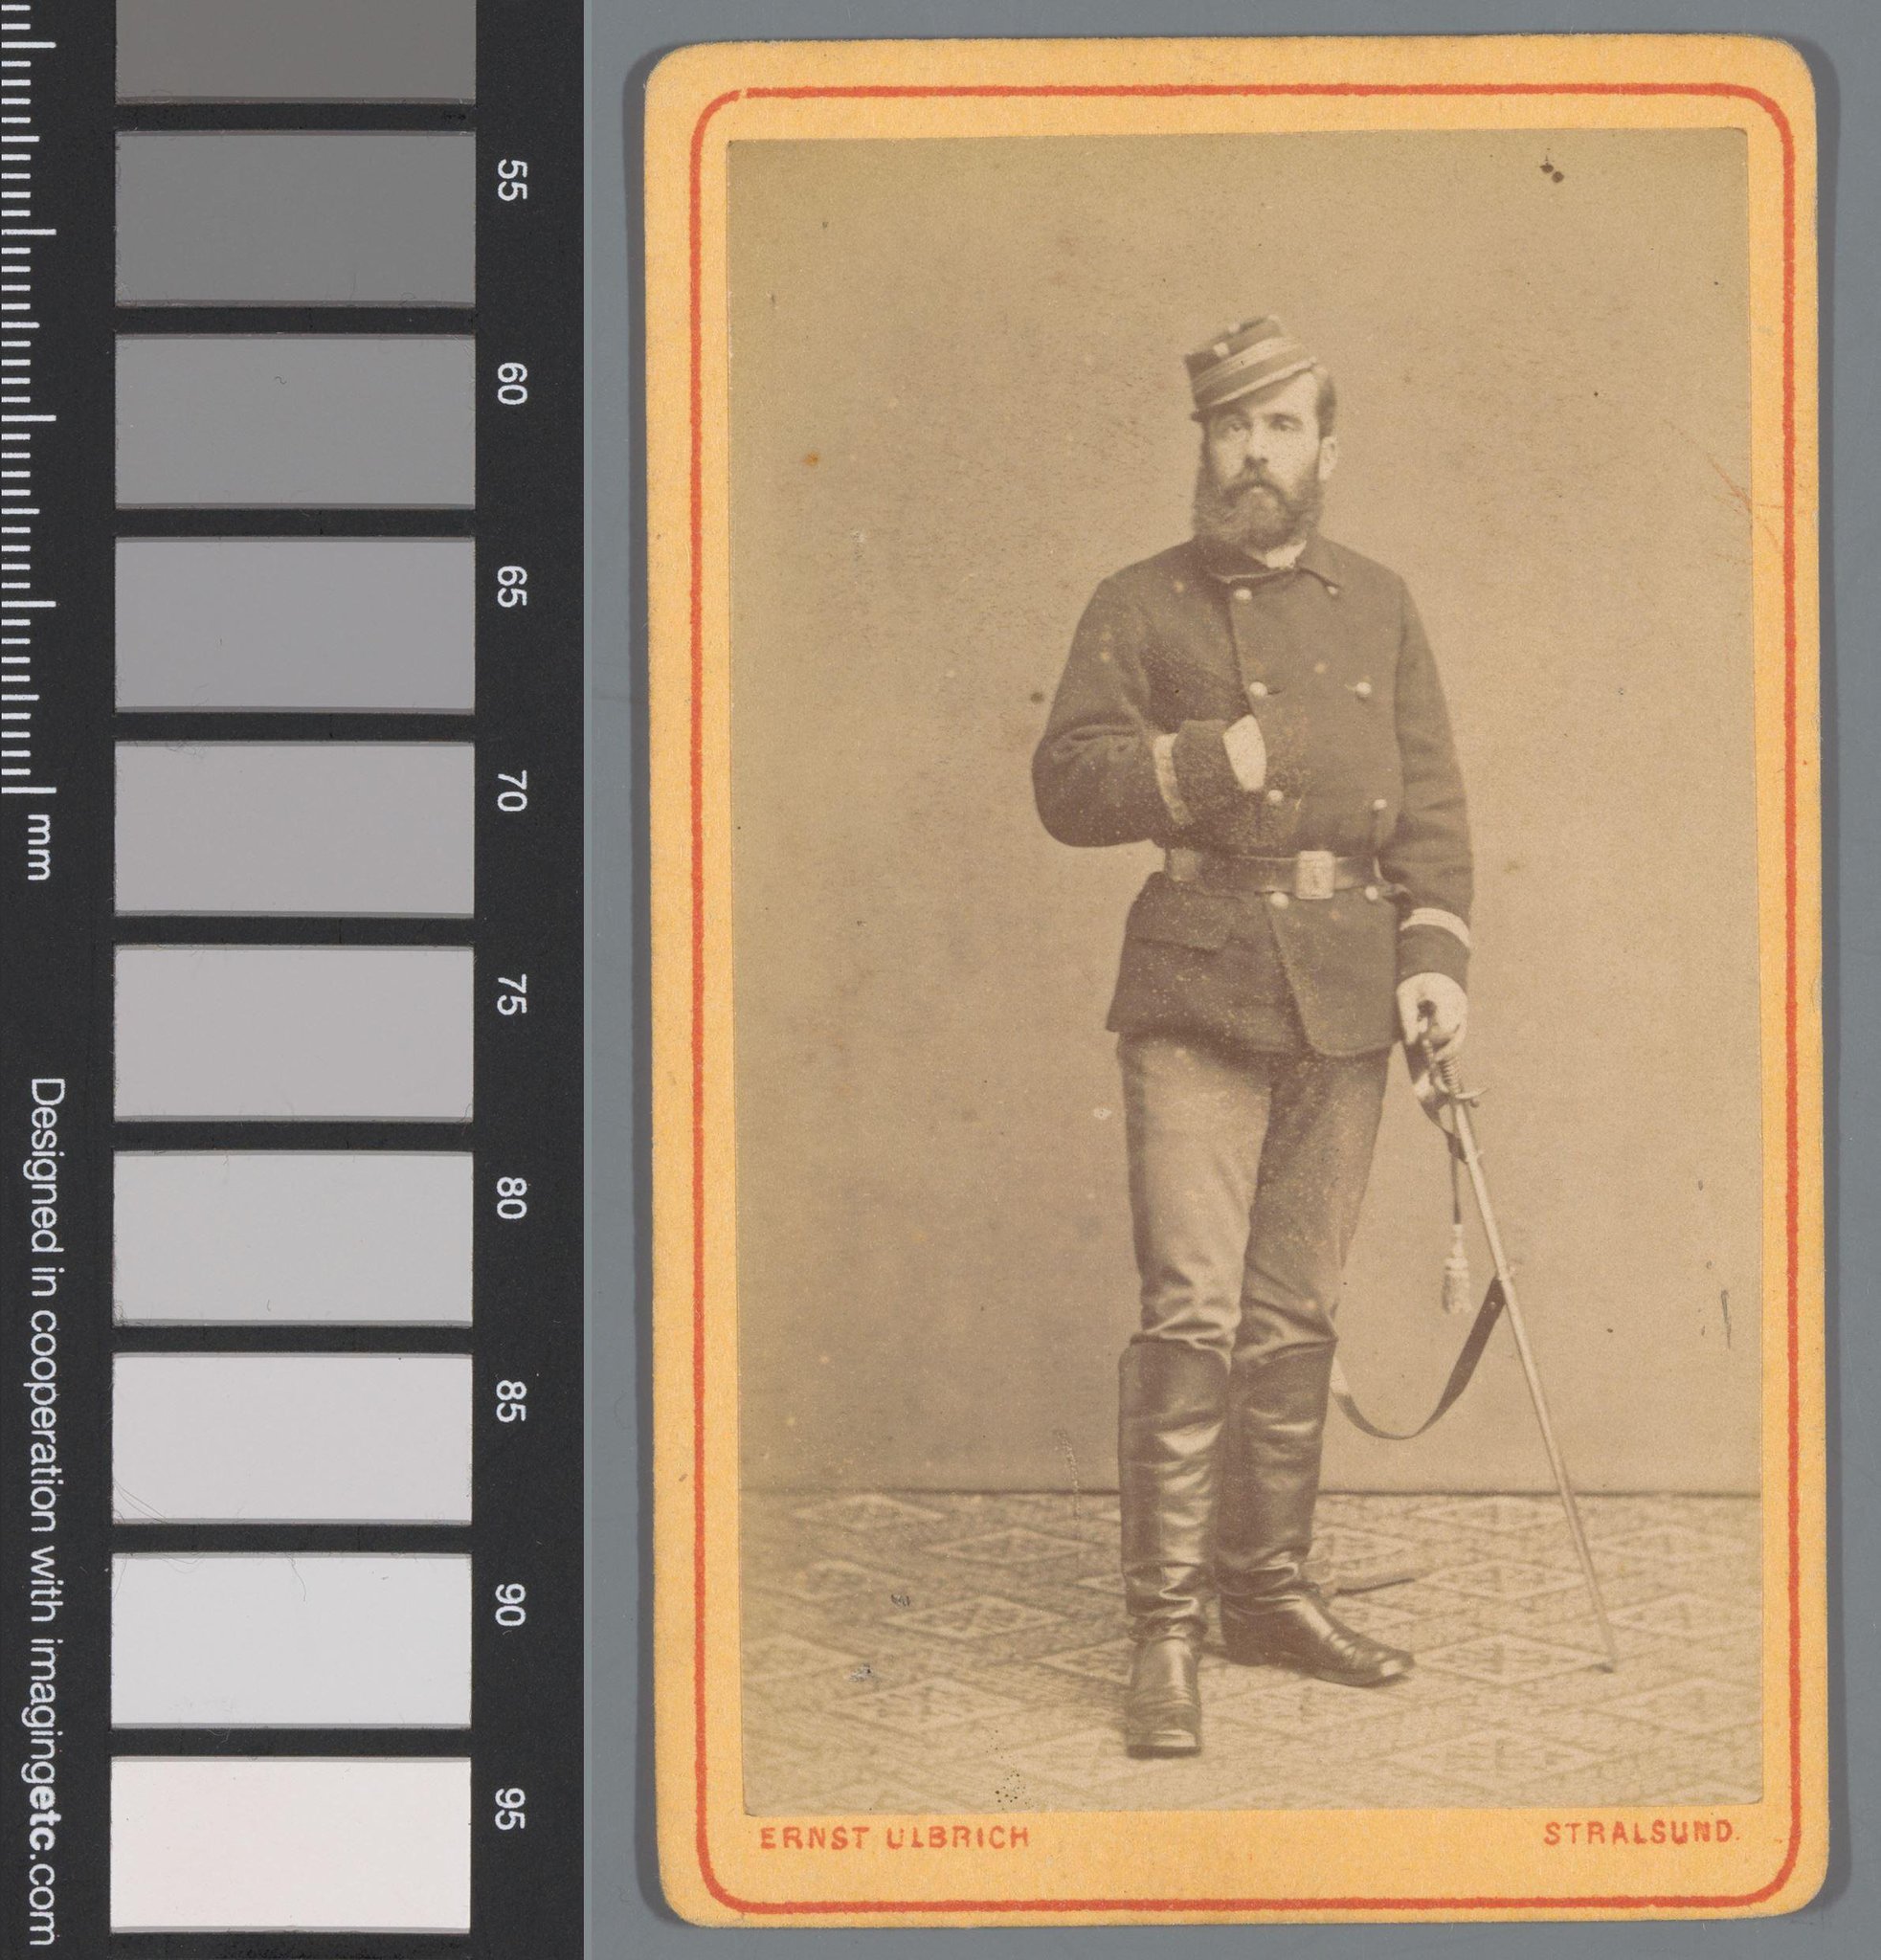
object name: carte de visite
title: Portret van een onbekende man in uniform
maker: ernst ulbrich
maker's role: fotograaf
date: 1869-1895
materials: cardboard, paper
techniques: albumen print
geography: stralsund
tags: adult man, anonymous historical person portrayed, (military) uniforms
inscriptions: inscription: ‘Ernst Ulbrich Stralsund’, inscription: ‘A mon ami E le/ Danois/ Souvenir de Captivité/ Haumauy/ Eernud Laumaillé/ Château de Houssaye/ Cne. de St Beauvenu de Pher/ par Segré/ Marne et Loire’